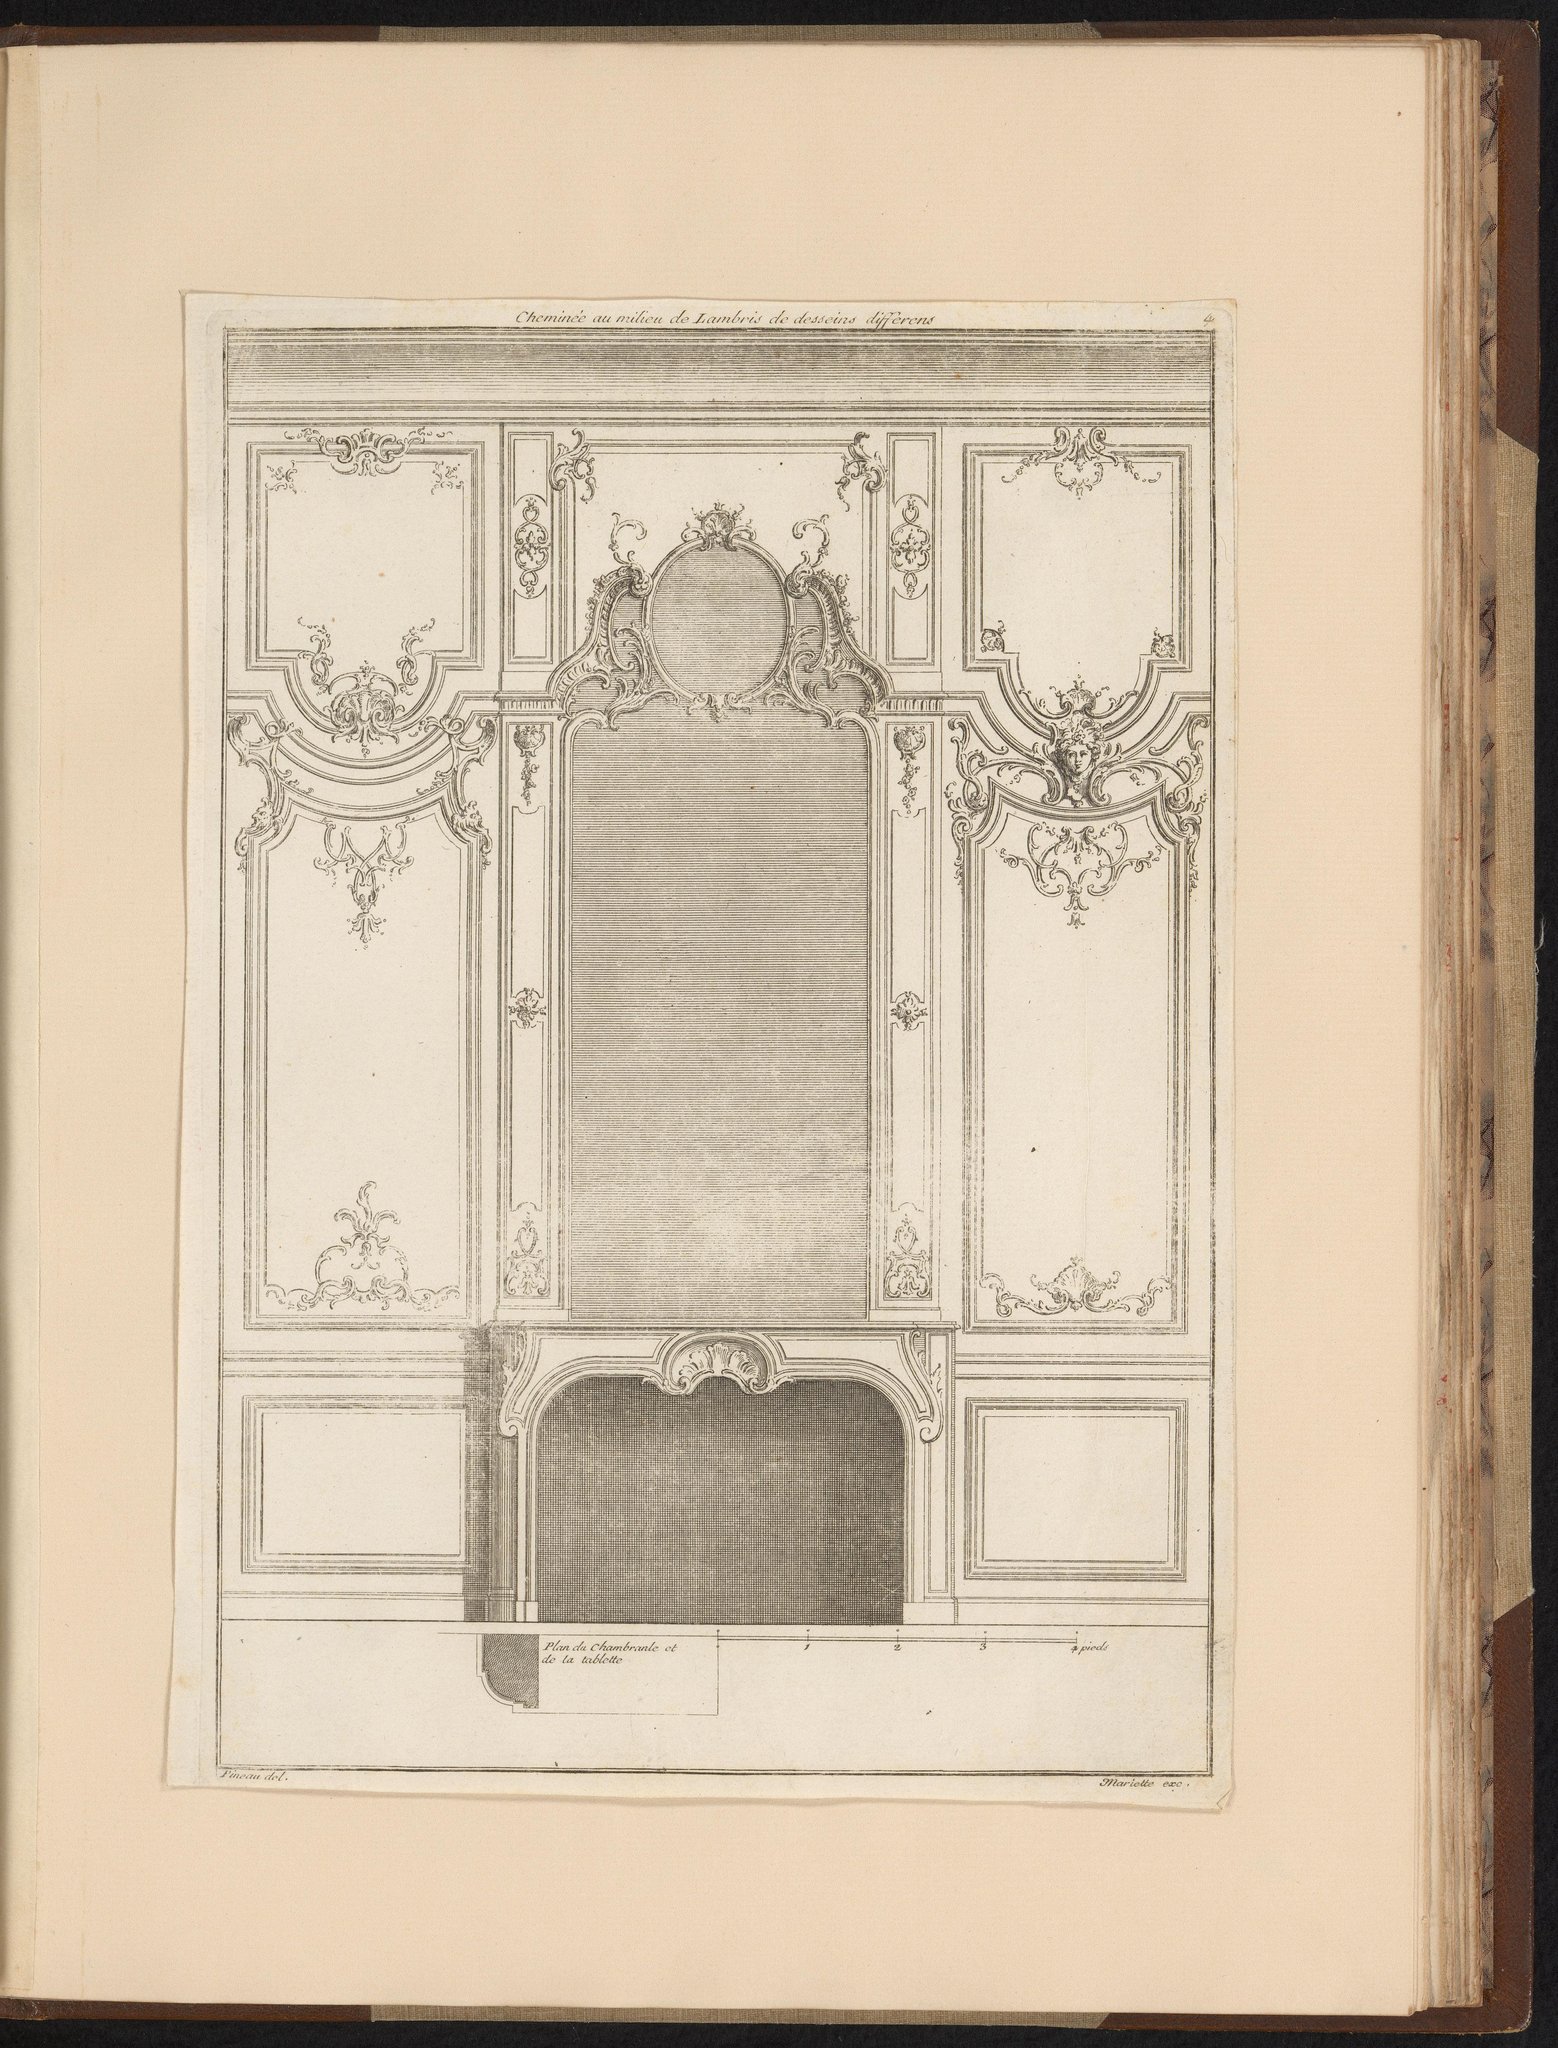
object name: print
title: Cheminée au milieu de lambris de desseins differens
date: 1725-1750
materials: paper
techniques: etching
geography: paris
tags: chimney, ornaments ~ art, panelling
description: Deze prent maakt deel uit van een album.